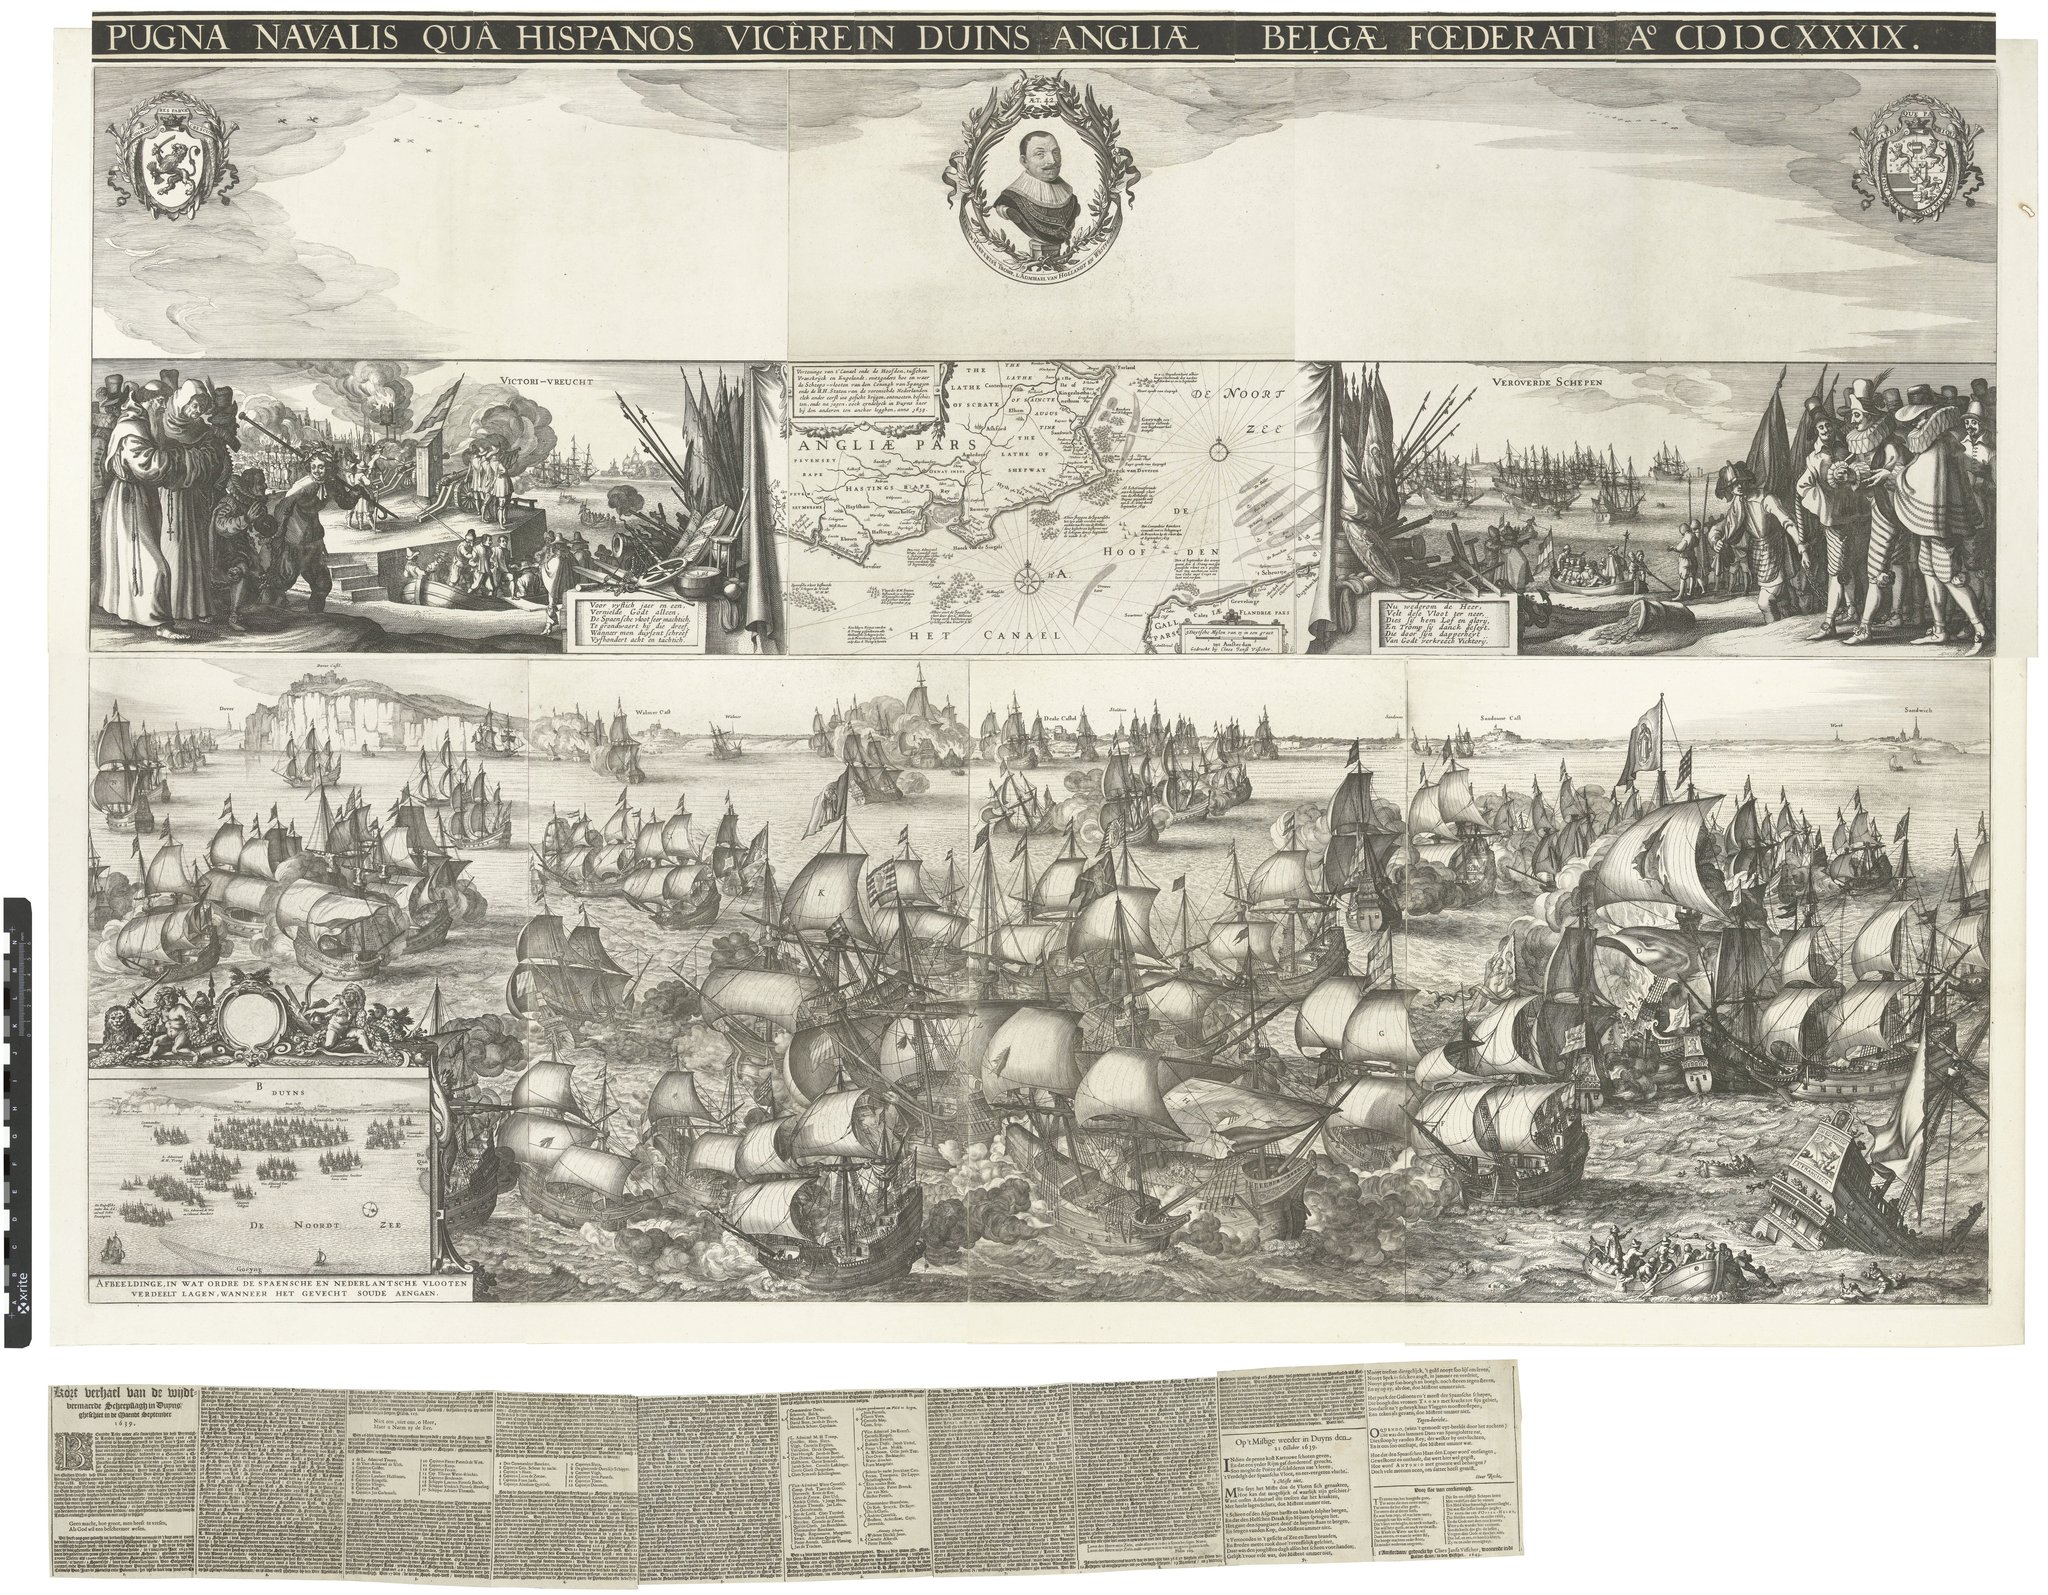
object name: print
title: De grote zeeslag bij Duins, 1639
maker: claes jansz. visscher (ii)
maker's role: draughtsman, print maker, publisher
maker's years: 1586-1652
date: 1640-1643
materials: paper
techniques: engraving, etching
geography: amsterdam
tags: brielle, maarten harpertszoon tromp, battle (+ naval force), battle of the downs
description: Grote voorstelling van de zeeslag bij Duins tussen de Spaanse vloot onder bevel van Antonio de Oquendo en de Staatse vloot onder Maarten Harpertsz. Tromp, 21 oktober 1639. Ongemonteerde ensemble bestaande uit 7 genummerde platen, de zwarte stroken met de titel en tekstblad met de beschrijving.